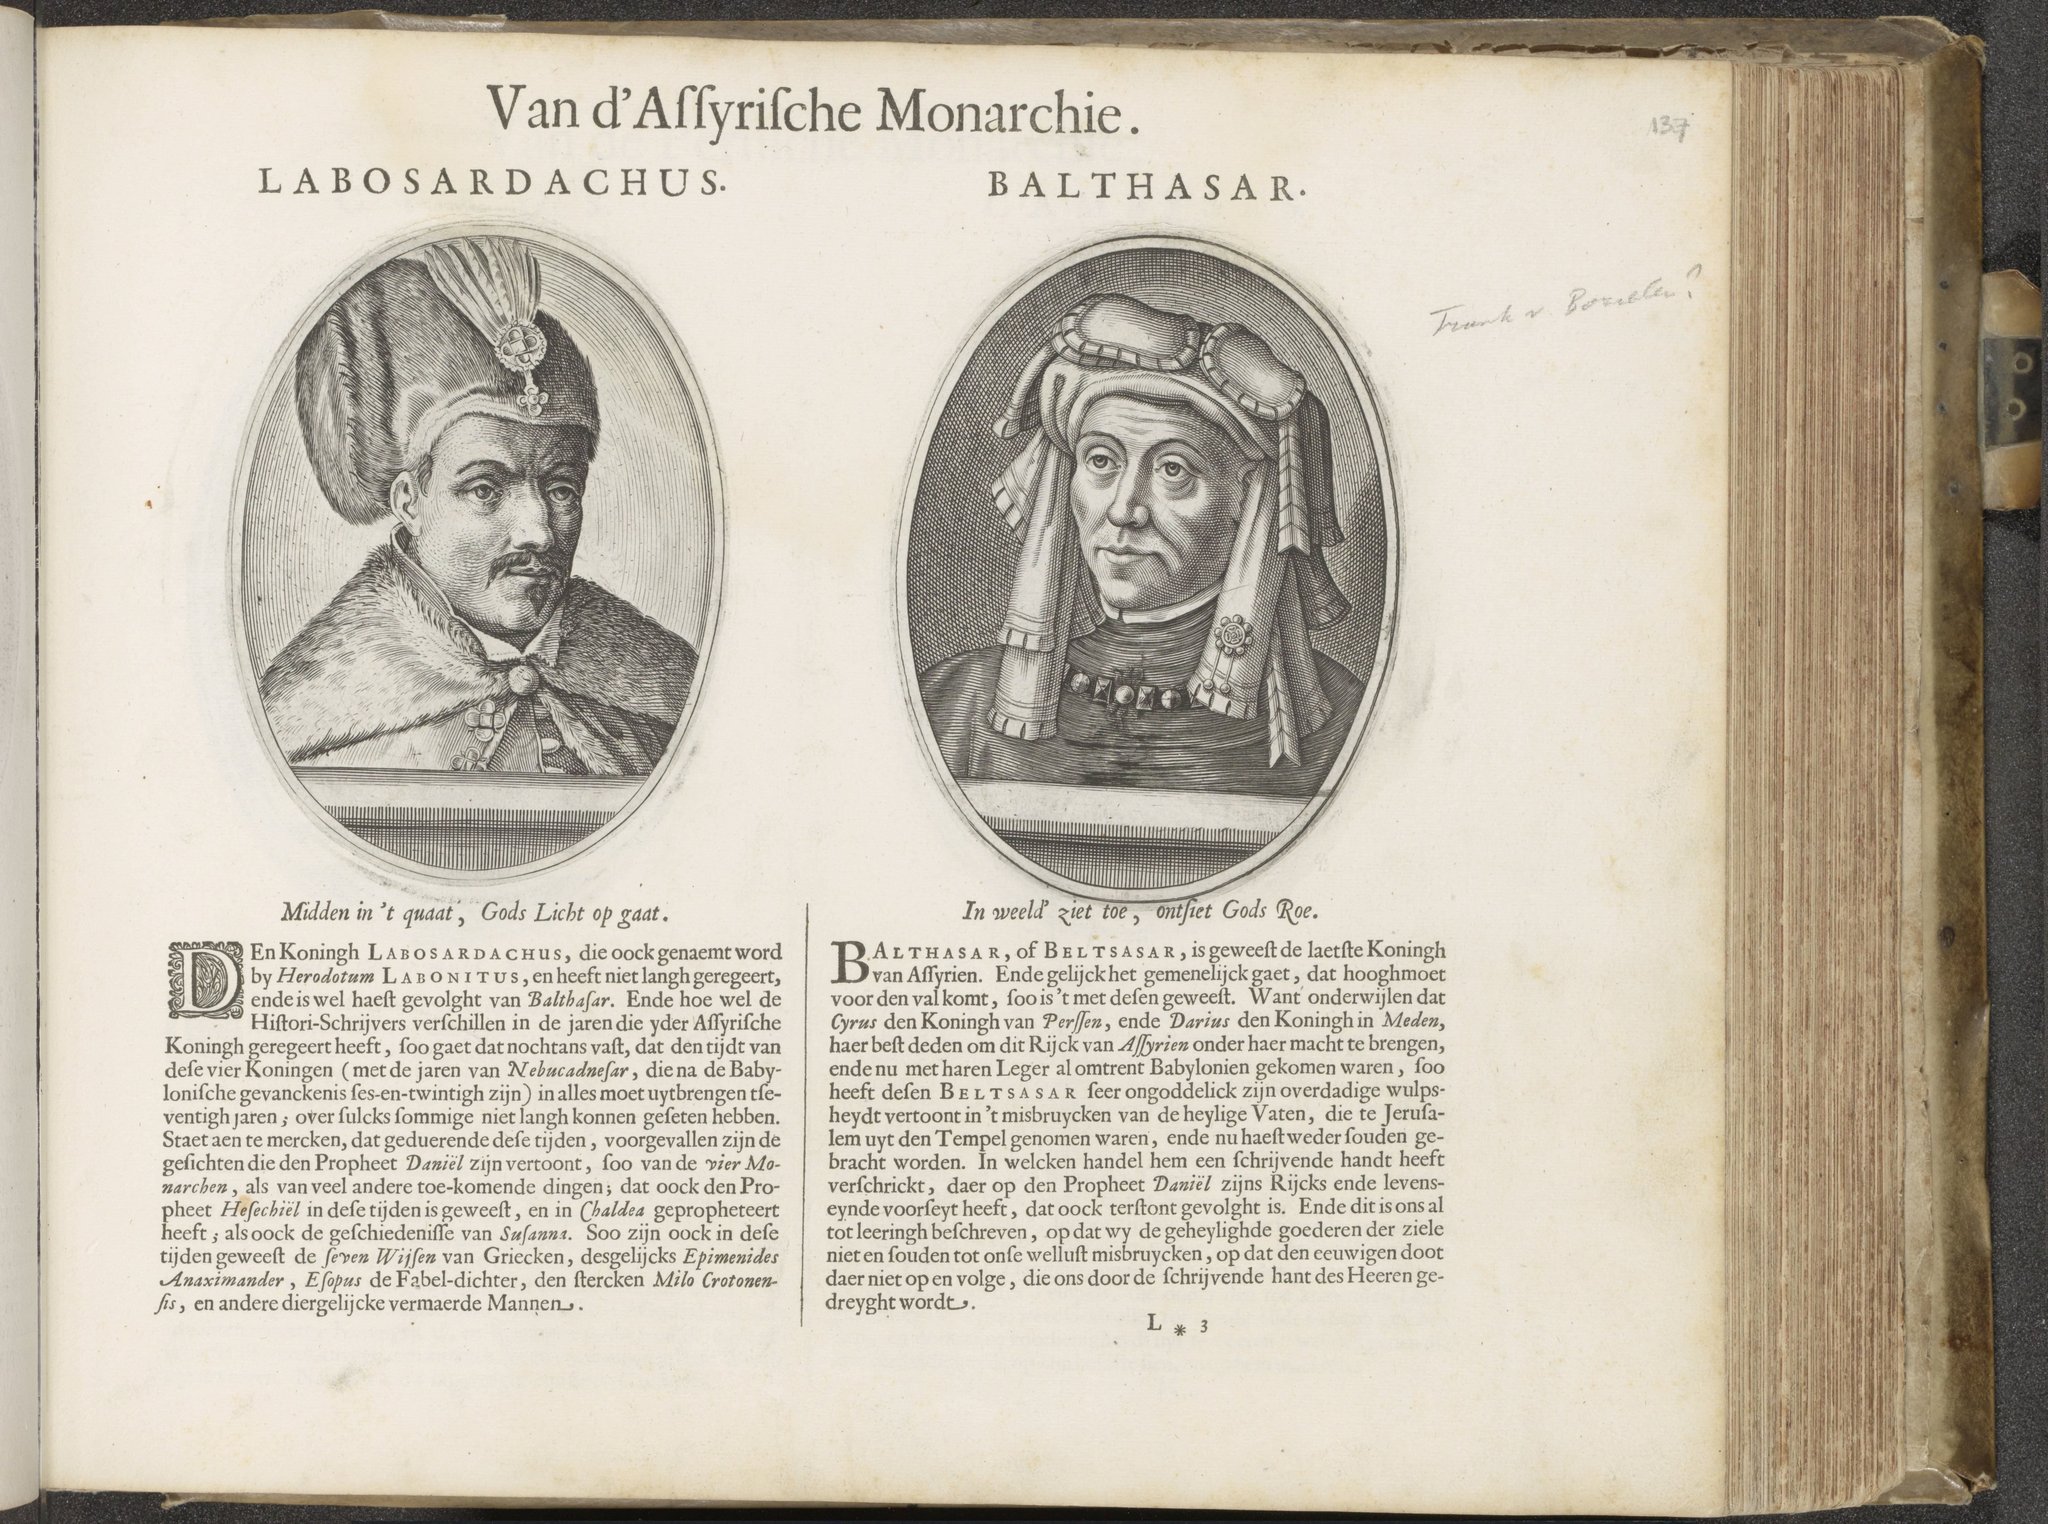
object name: album leaf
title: Den Grooten Emblemata Sacra, bestaande in meer dan vier hondert bybelsche figuren, zoo des Ouden als des Nieuwen Testaments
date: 1610-1625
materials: paper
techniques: engraving, letterpress printing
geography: amsterdam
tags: brielle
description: Portretten van Dimitri I van Rusland en Frank van Borselen, in dit album gebruikt als afbeeldingen van respectievelijk Nabonidus en Belsazar. De begeleidende tekst begint met een kleine gedecoreerde initiaal D. Het blad maakt deel uit van een album.